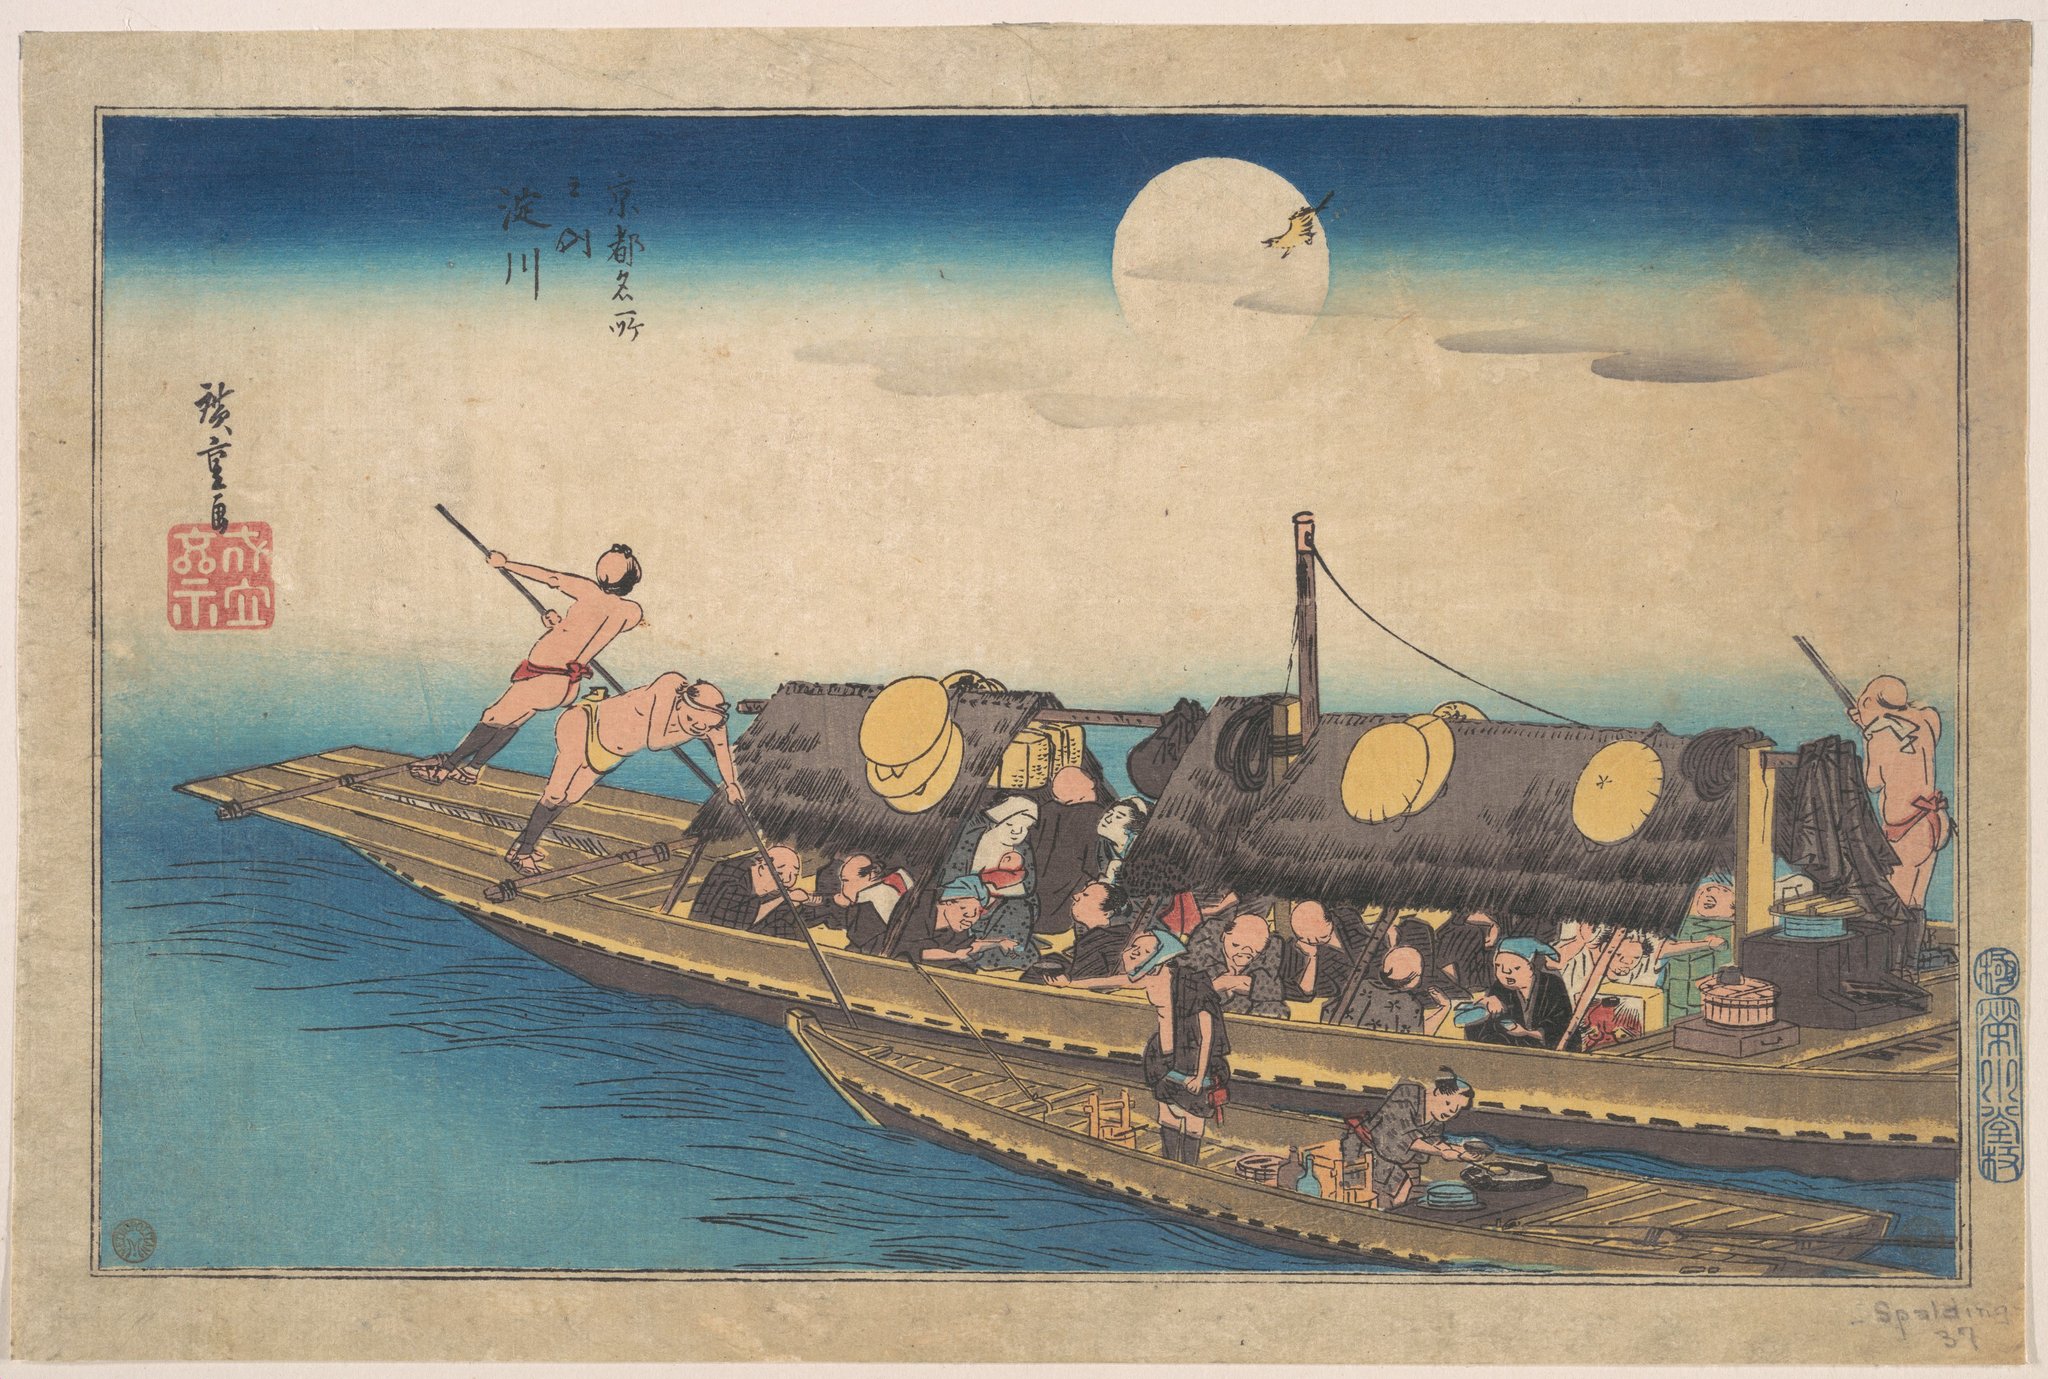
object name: print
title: Yodogawa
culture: japanese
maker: utagawa hiroshige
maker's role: artist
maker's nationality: japanese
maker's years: 1797-1858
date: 1834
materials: ink, paper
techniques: woodblock print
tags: men,boats